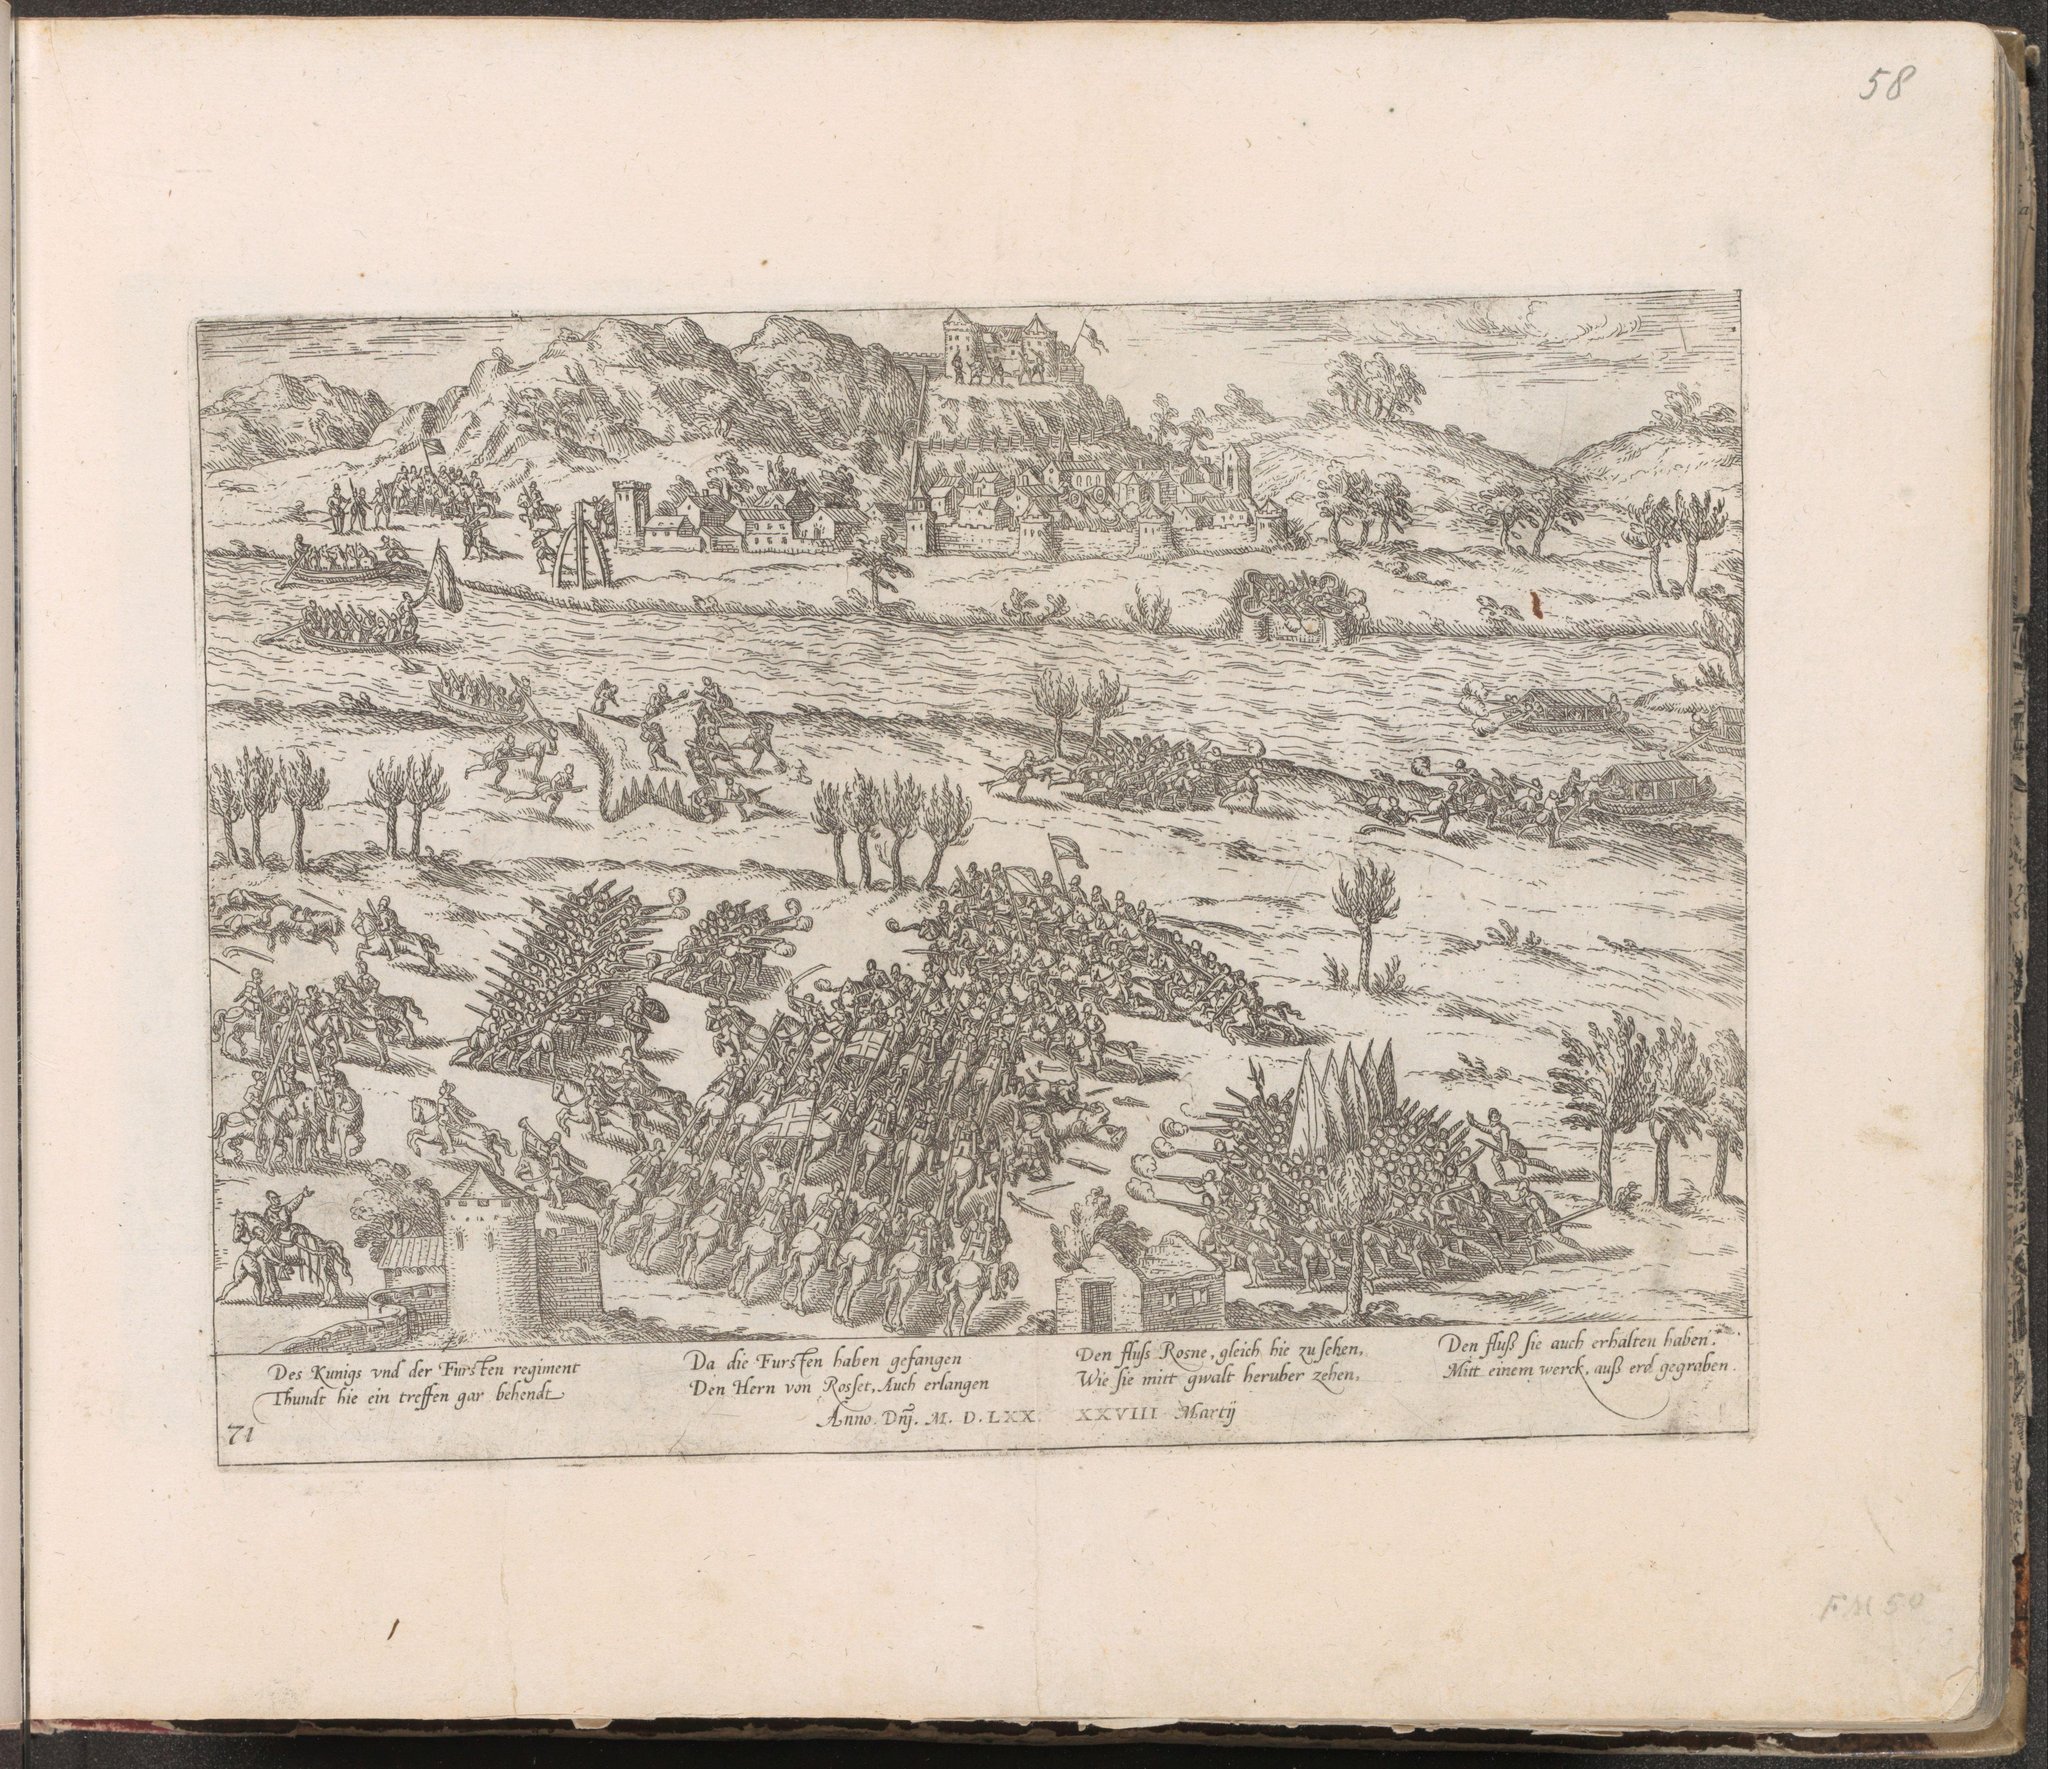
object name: album leaf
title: Serie 3: Franse Godsdienstoorlogen, 1559-1573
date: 1570-1571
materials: paper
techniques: etching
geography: cologne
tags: battle, fighting in general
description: Slag bij de Rhône, 28 maart 1570. Veldslag tussen twee legers aan de oever van de rivier. Met onderschrift van 8 regels in het Duits. Linksonder genummerd: 71. De prent maakt deel uit van een album.